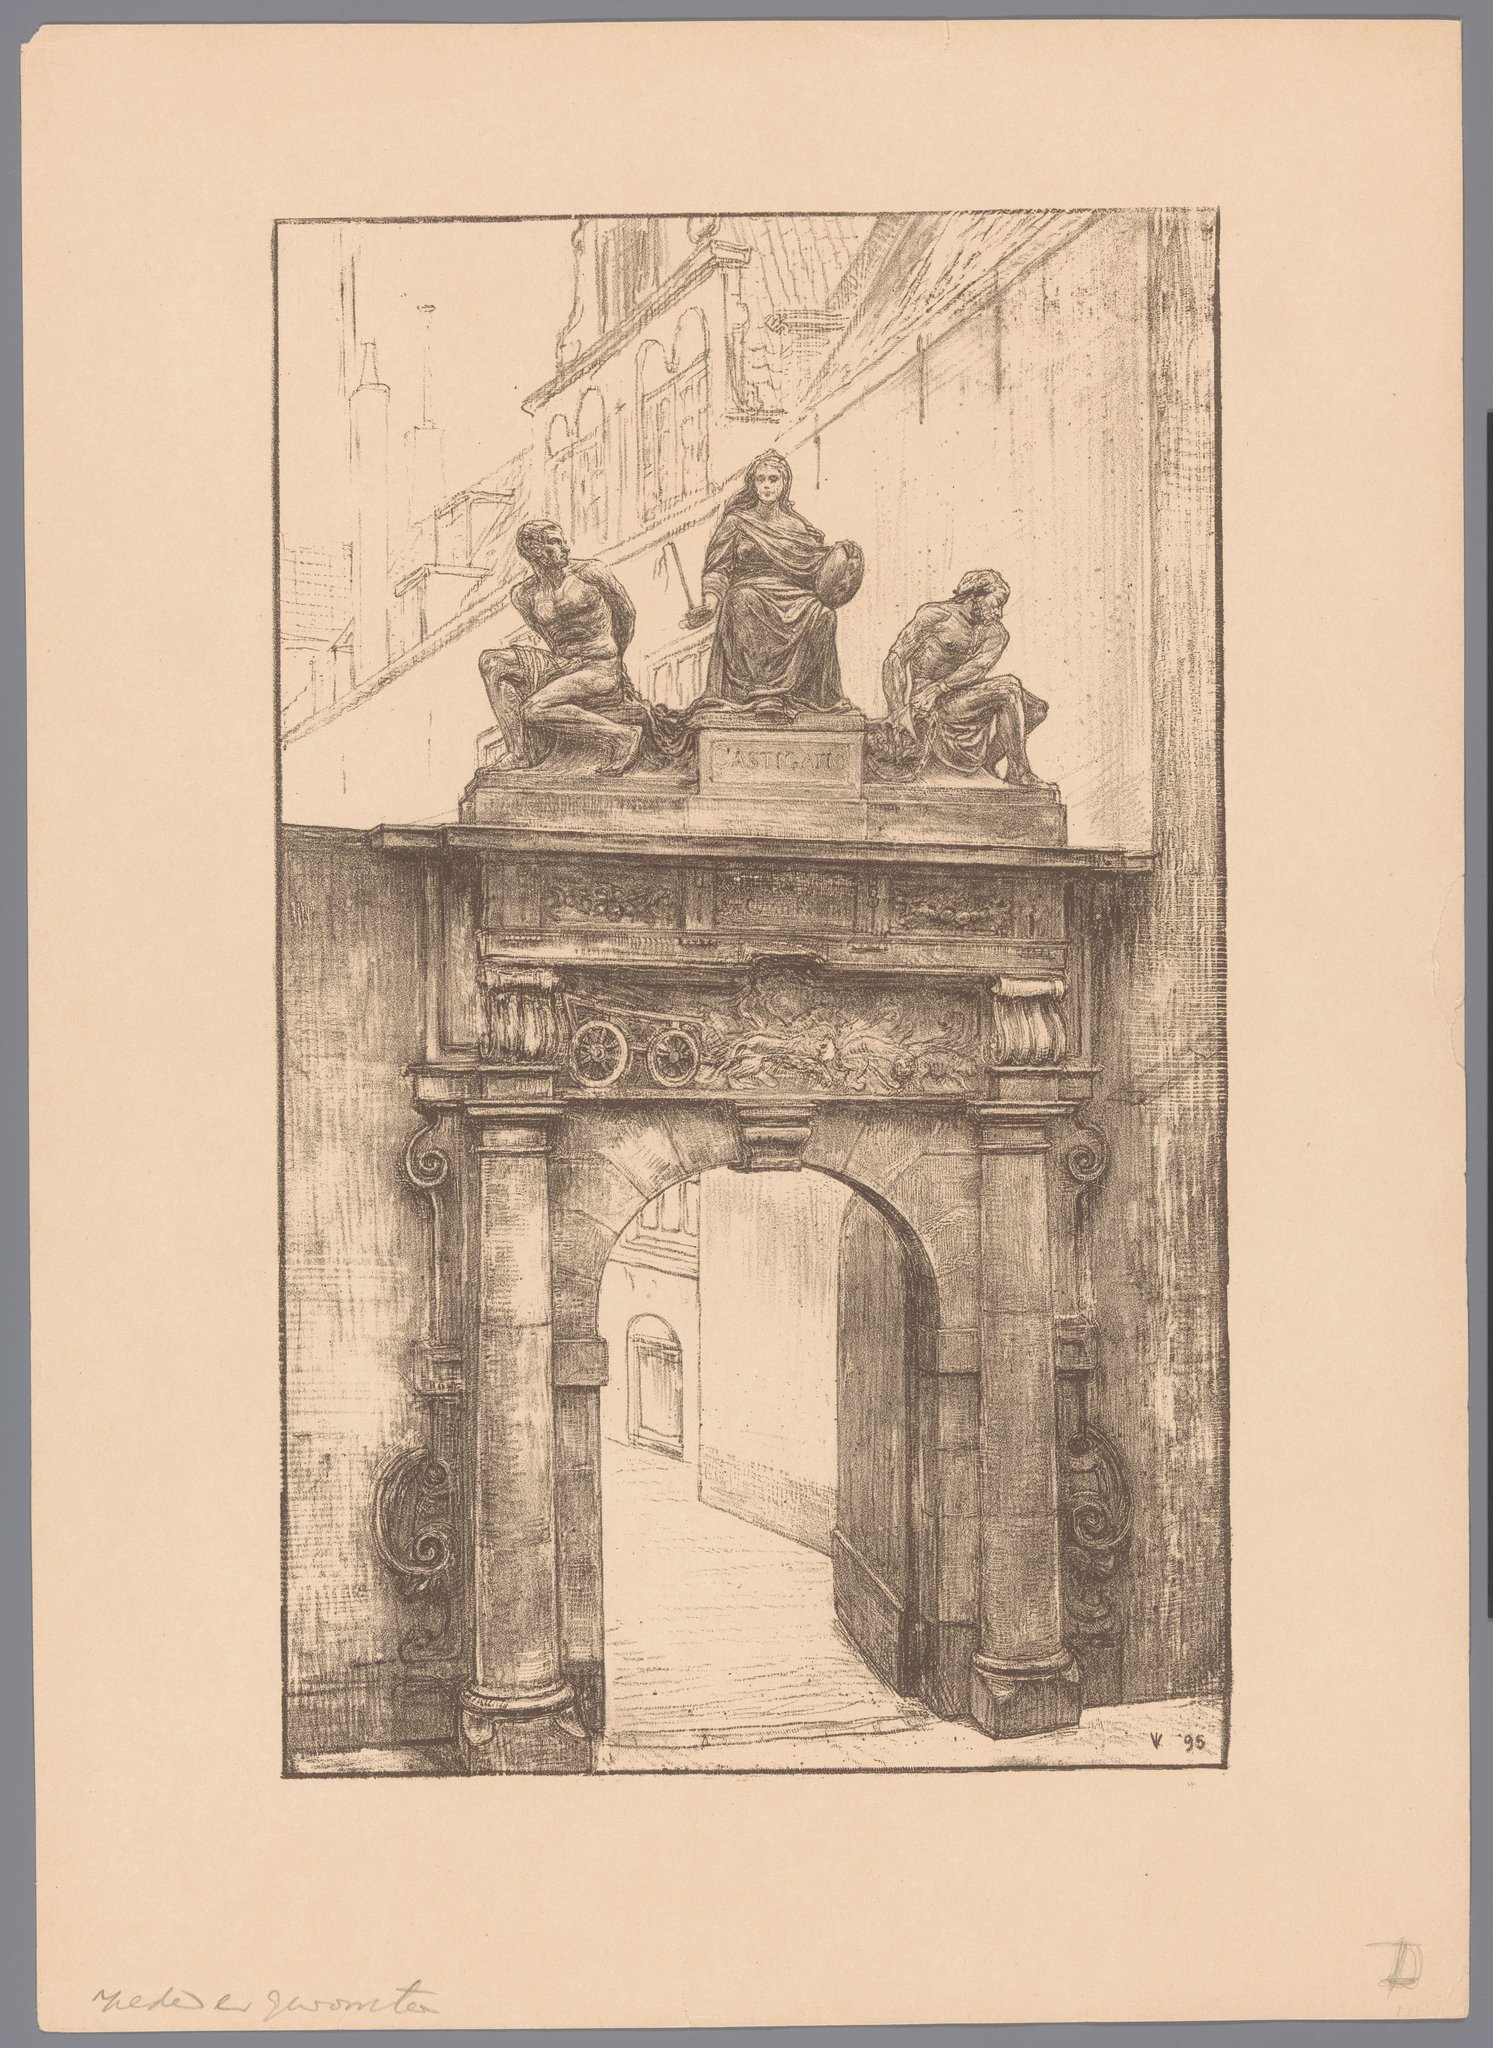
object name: print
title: Rasphuispoort te Amsterdam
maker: jan veth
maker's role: designer, draughtsman, painter, print maker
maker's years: 1864-1925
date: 1895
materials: paper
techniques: lithograph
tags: gate, entrance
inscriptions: collector's mark: Lugt 2228